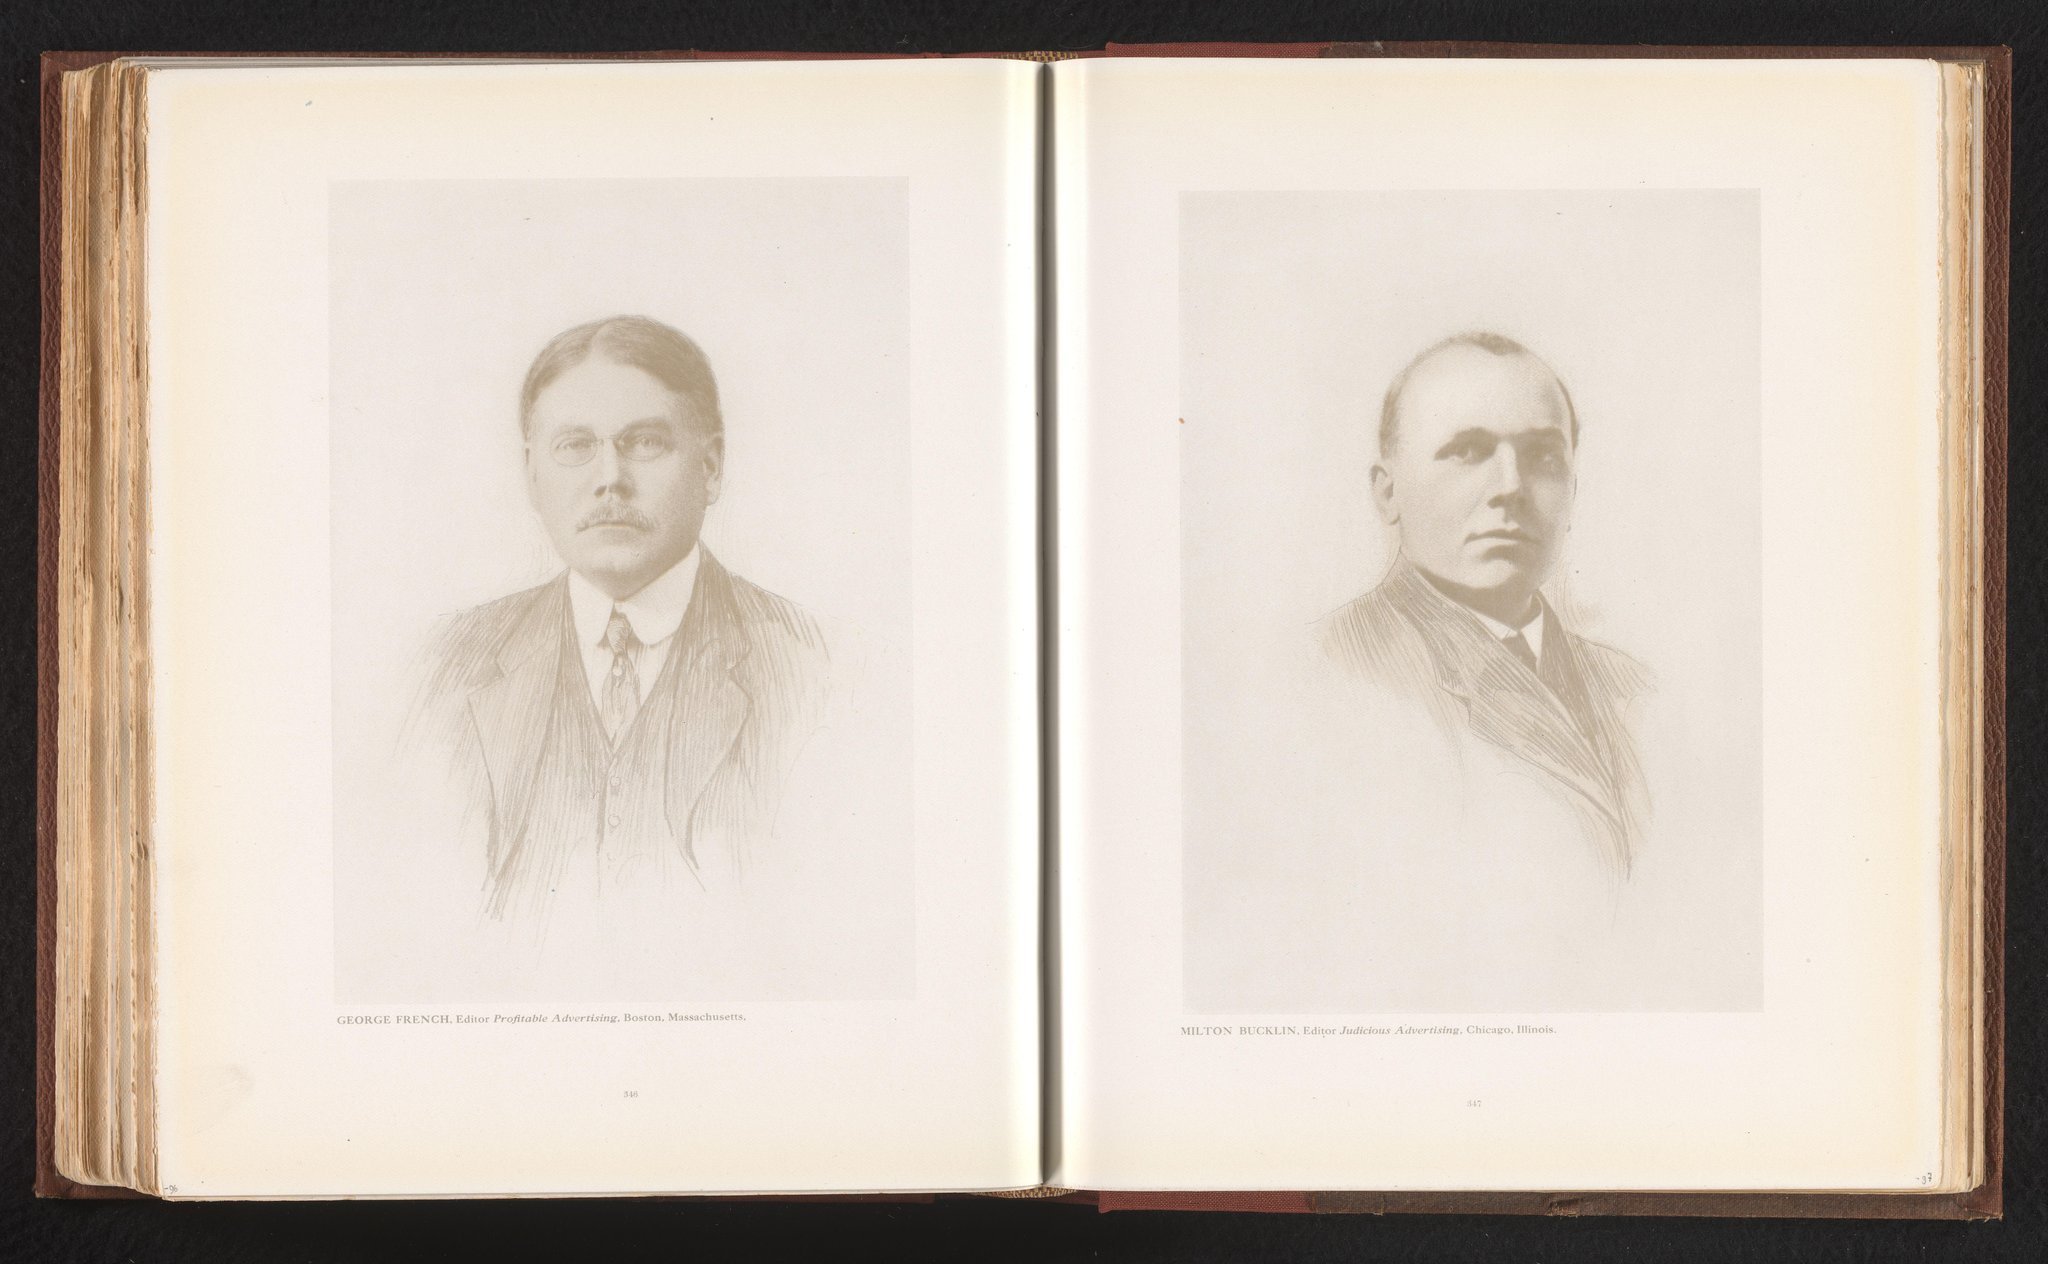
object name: reproduction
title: Milton Bucklin, Editor Judicious Advertising, Chicago, Illinois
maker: Anonymous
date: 1904-1909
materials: paper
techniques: autotype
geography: hamilton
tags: adult man, historical persons